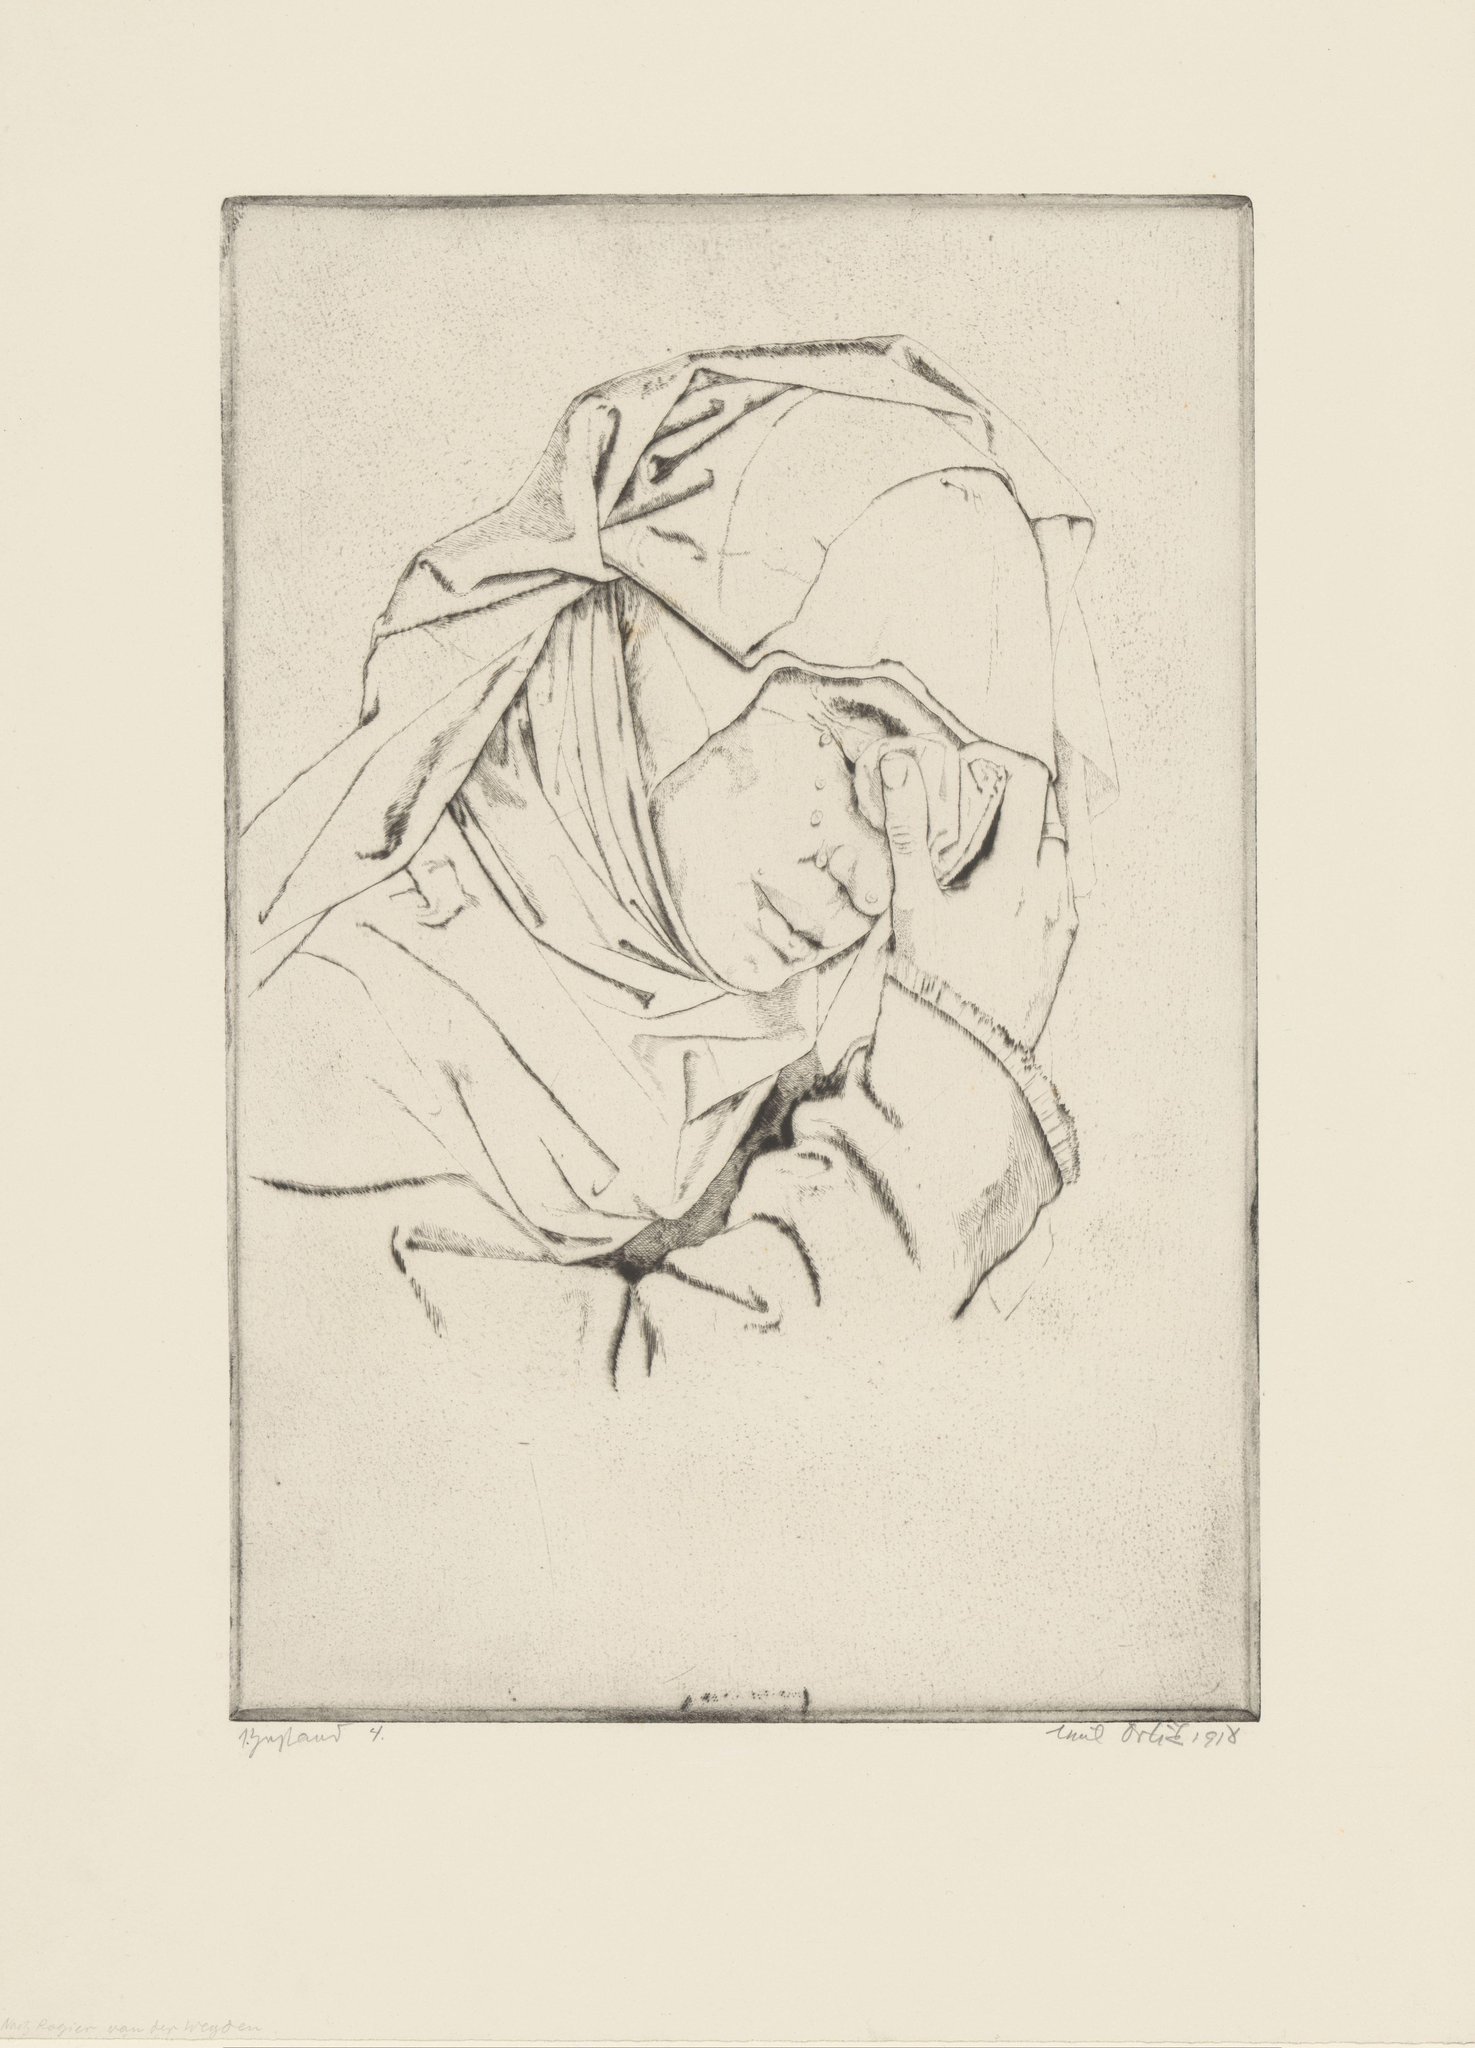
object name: print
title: De rouwende Maria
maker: emil orlik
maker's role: painter, print maker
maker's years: 1870-1932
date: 1918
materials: paper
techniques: drypoint, etching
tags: 'mater dolorosa' - ff - 'mater dolorosa', head or bust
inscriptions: name: ‘Emil Orlik 1918’, collector's mark: Lugt 2228, name